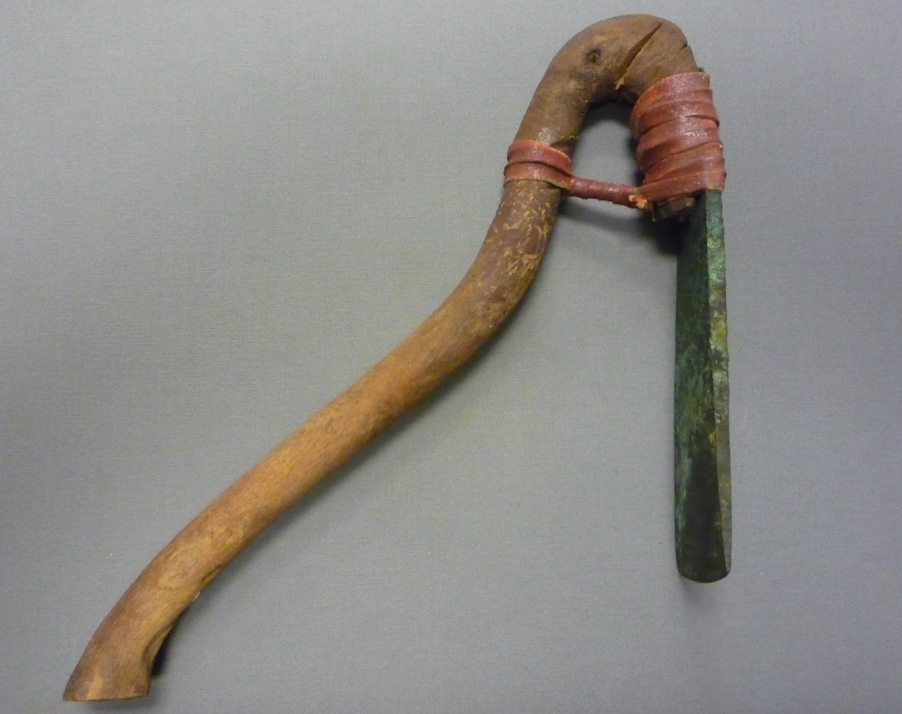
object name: adze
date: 1550-1295 BCE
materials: bronze, copper alloy, leather, wood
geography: egypt